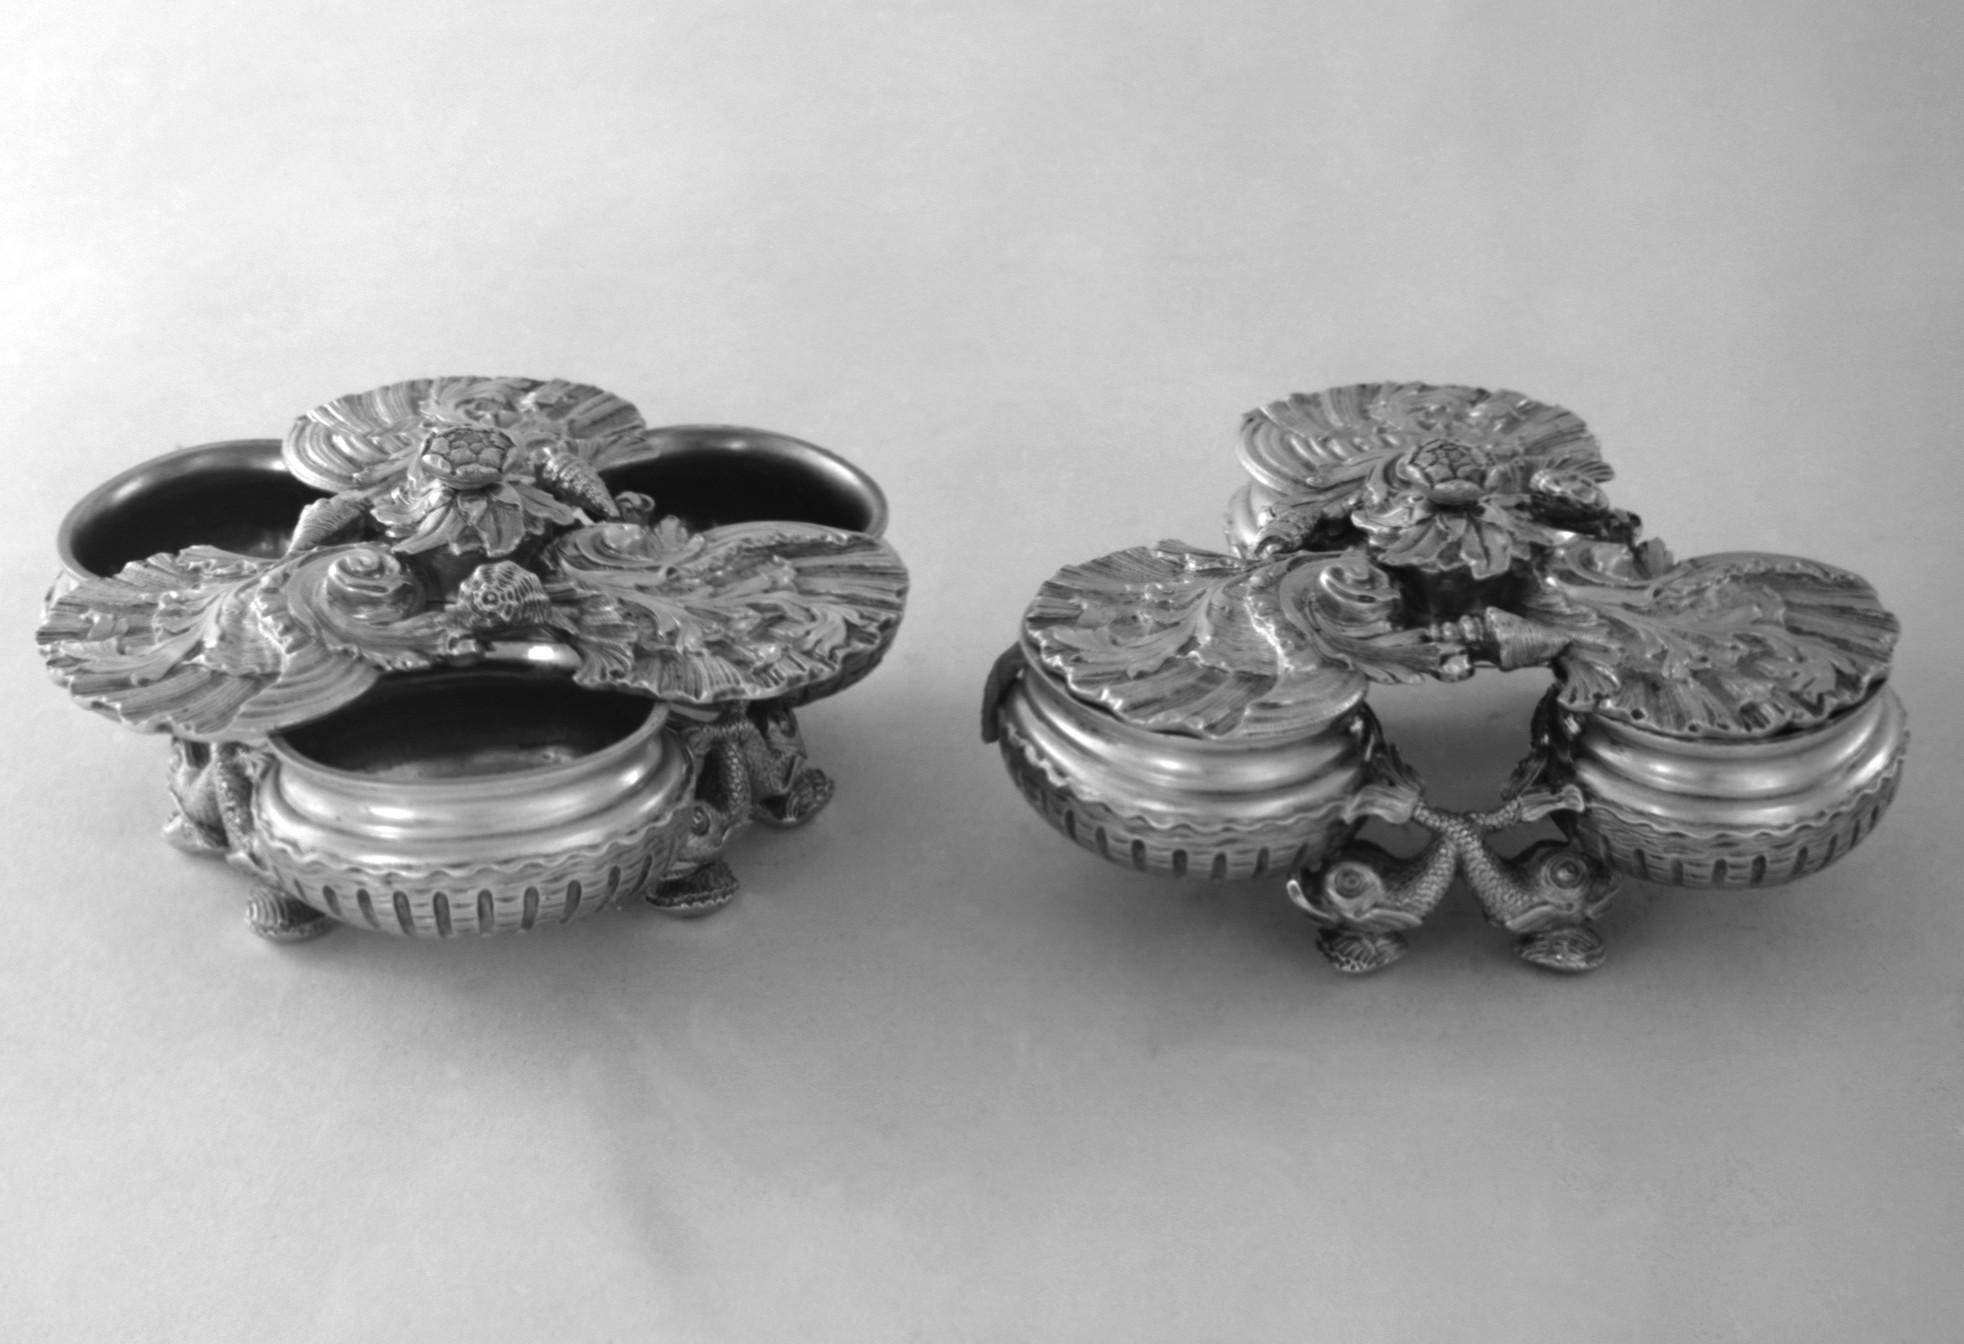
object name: salt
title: Pair of triple salts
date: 1745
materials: silver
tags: flowers